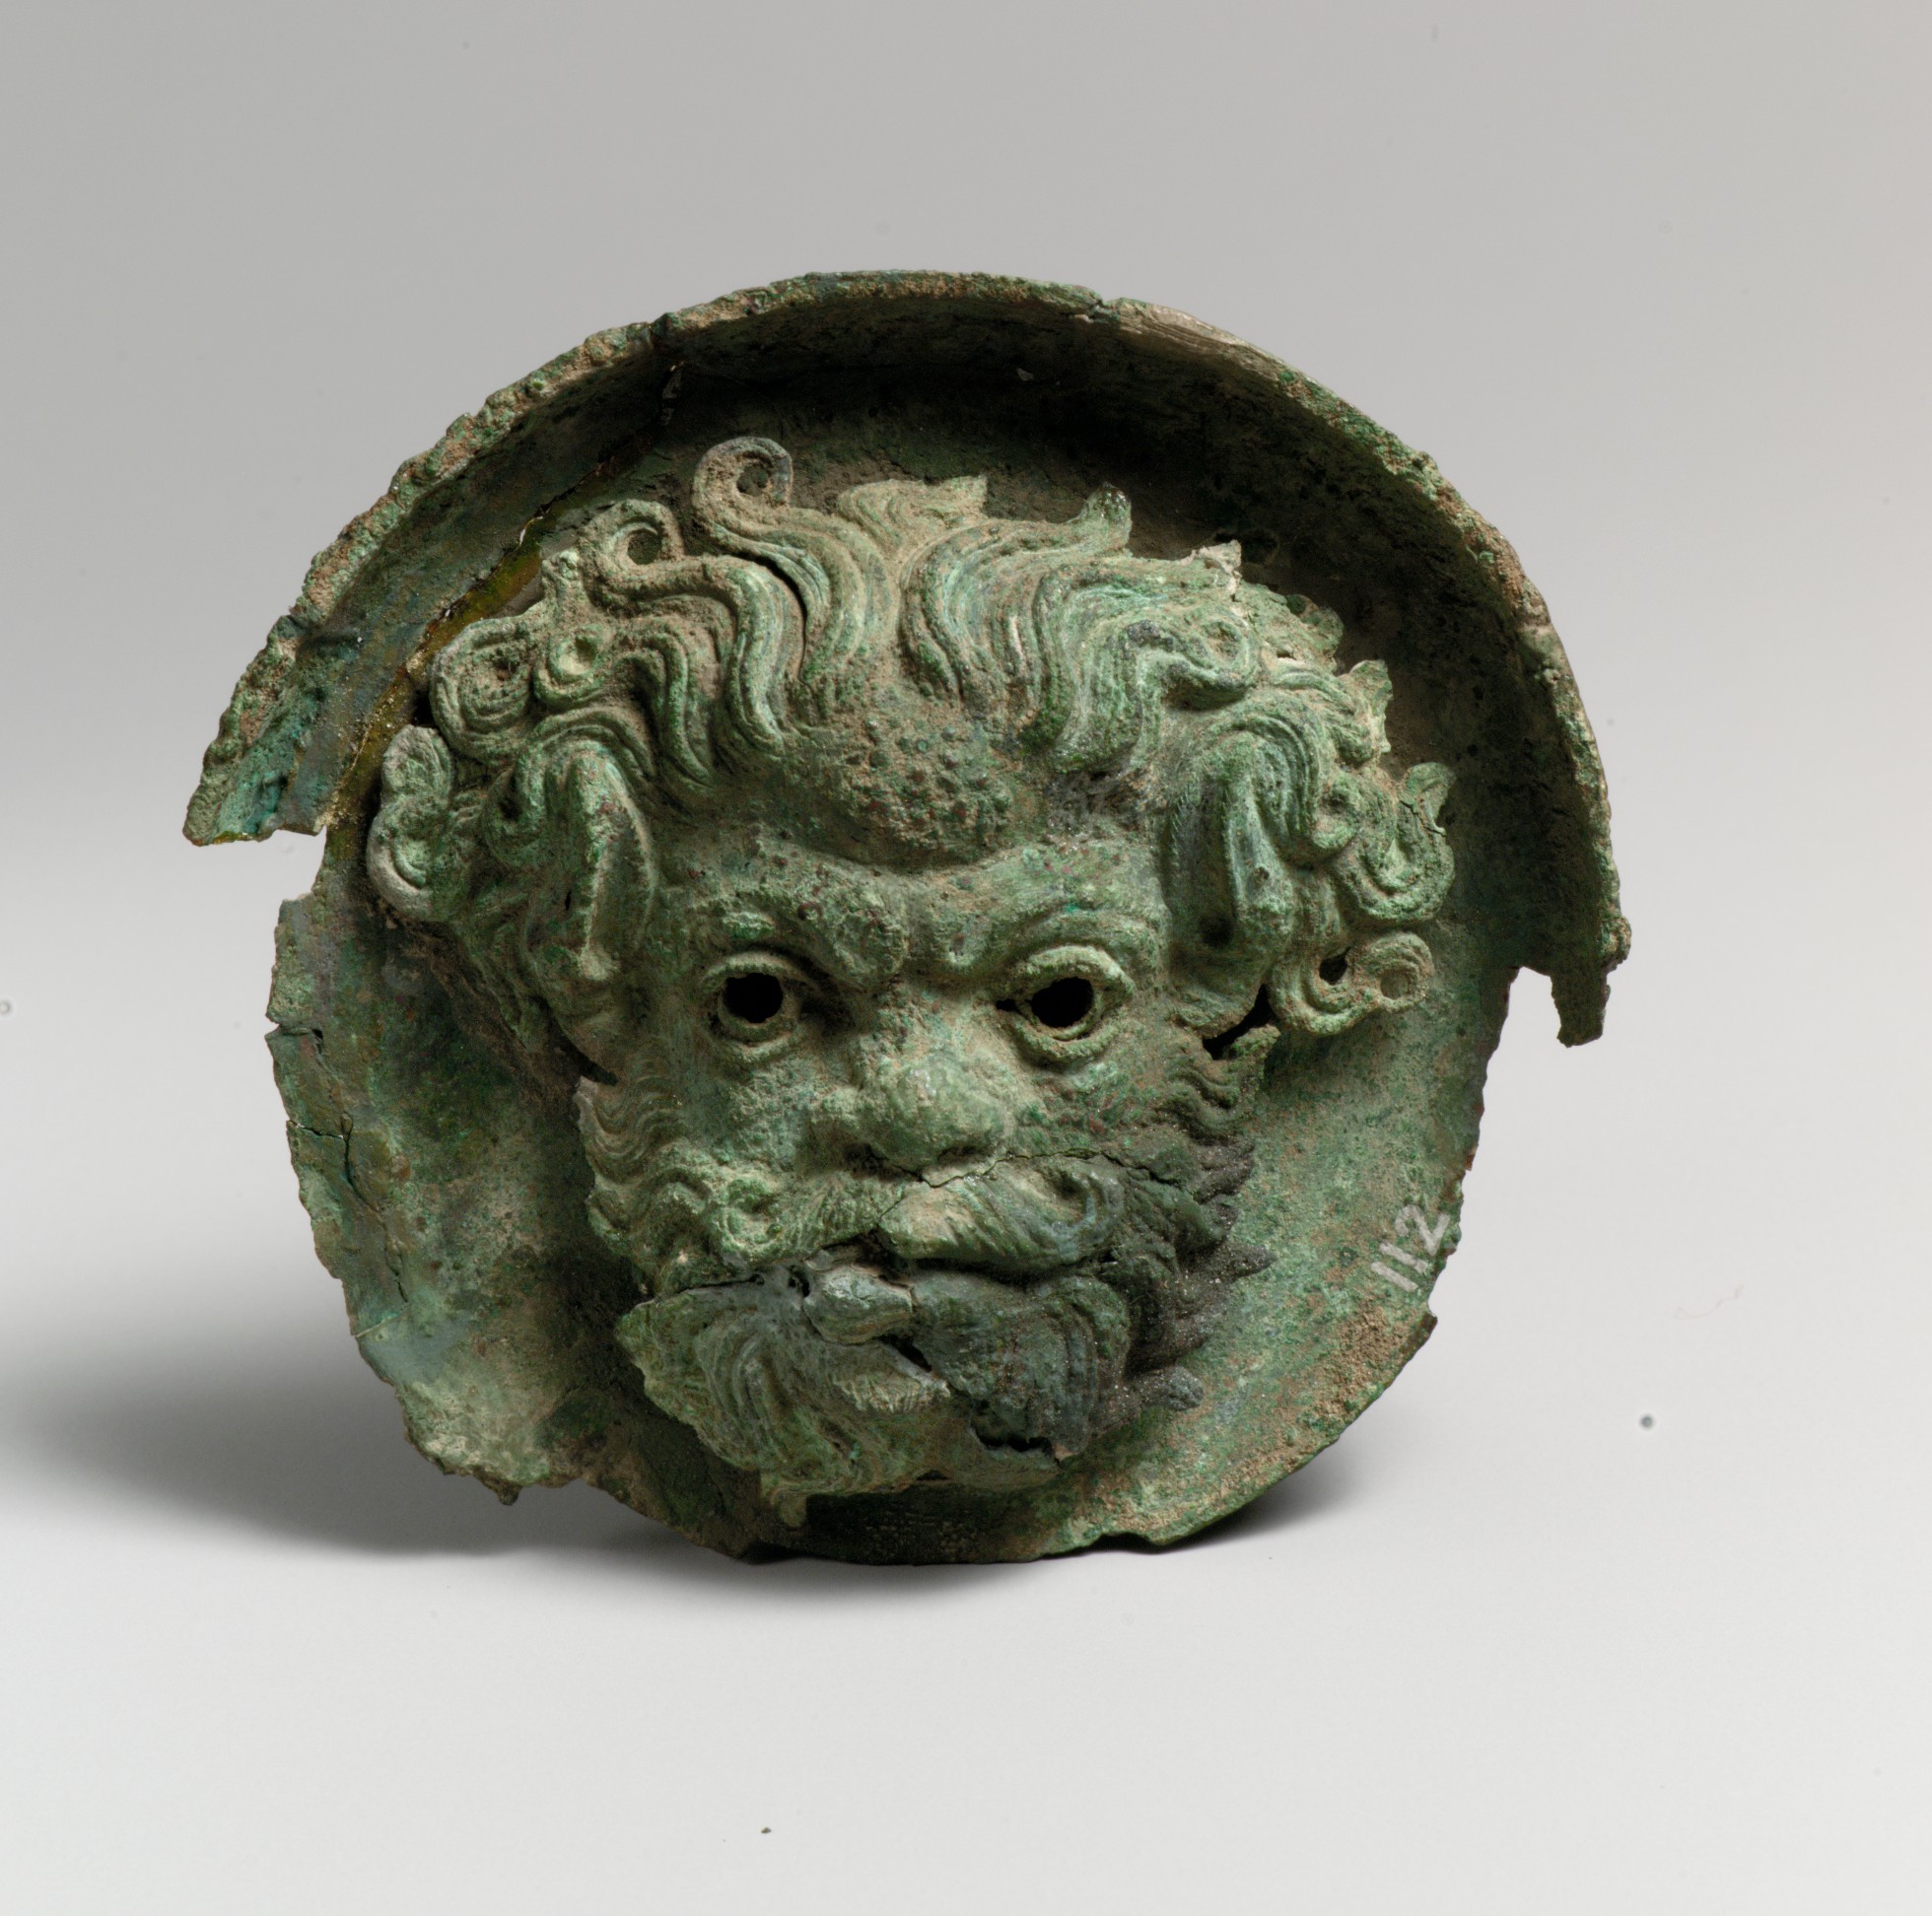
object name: relief of a satyr's head, old man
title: Silvered bronze roundel with satyr head (one of a pair)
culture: greek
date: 325-300 BCE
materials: bronze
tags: satyrs